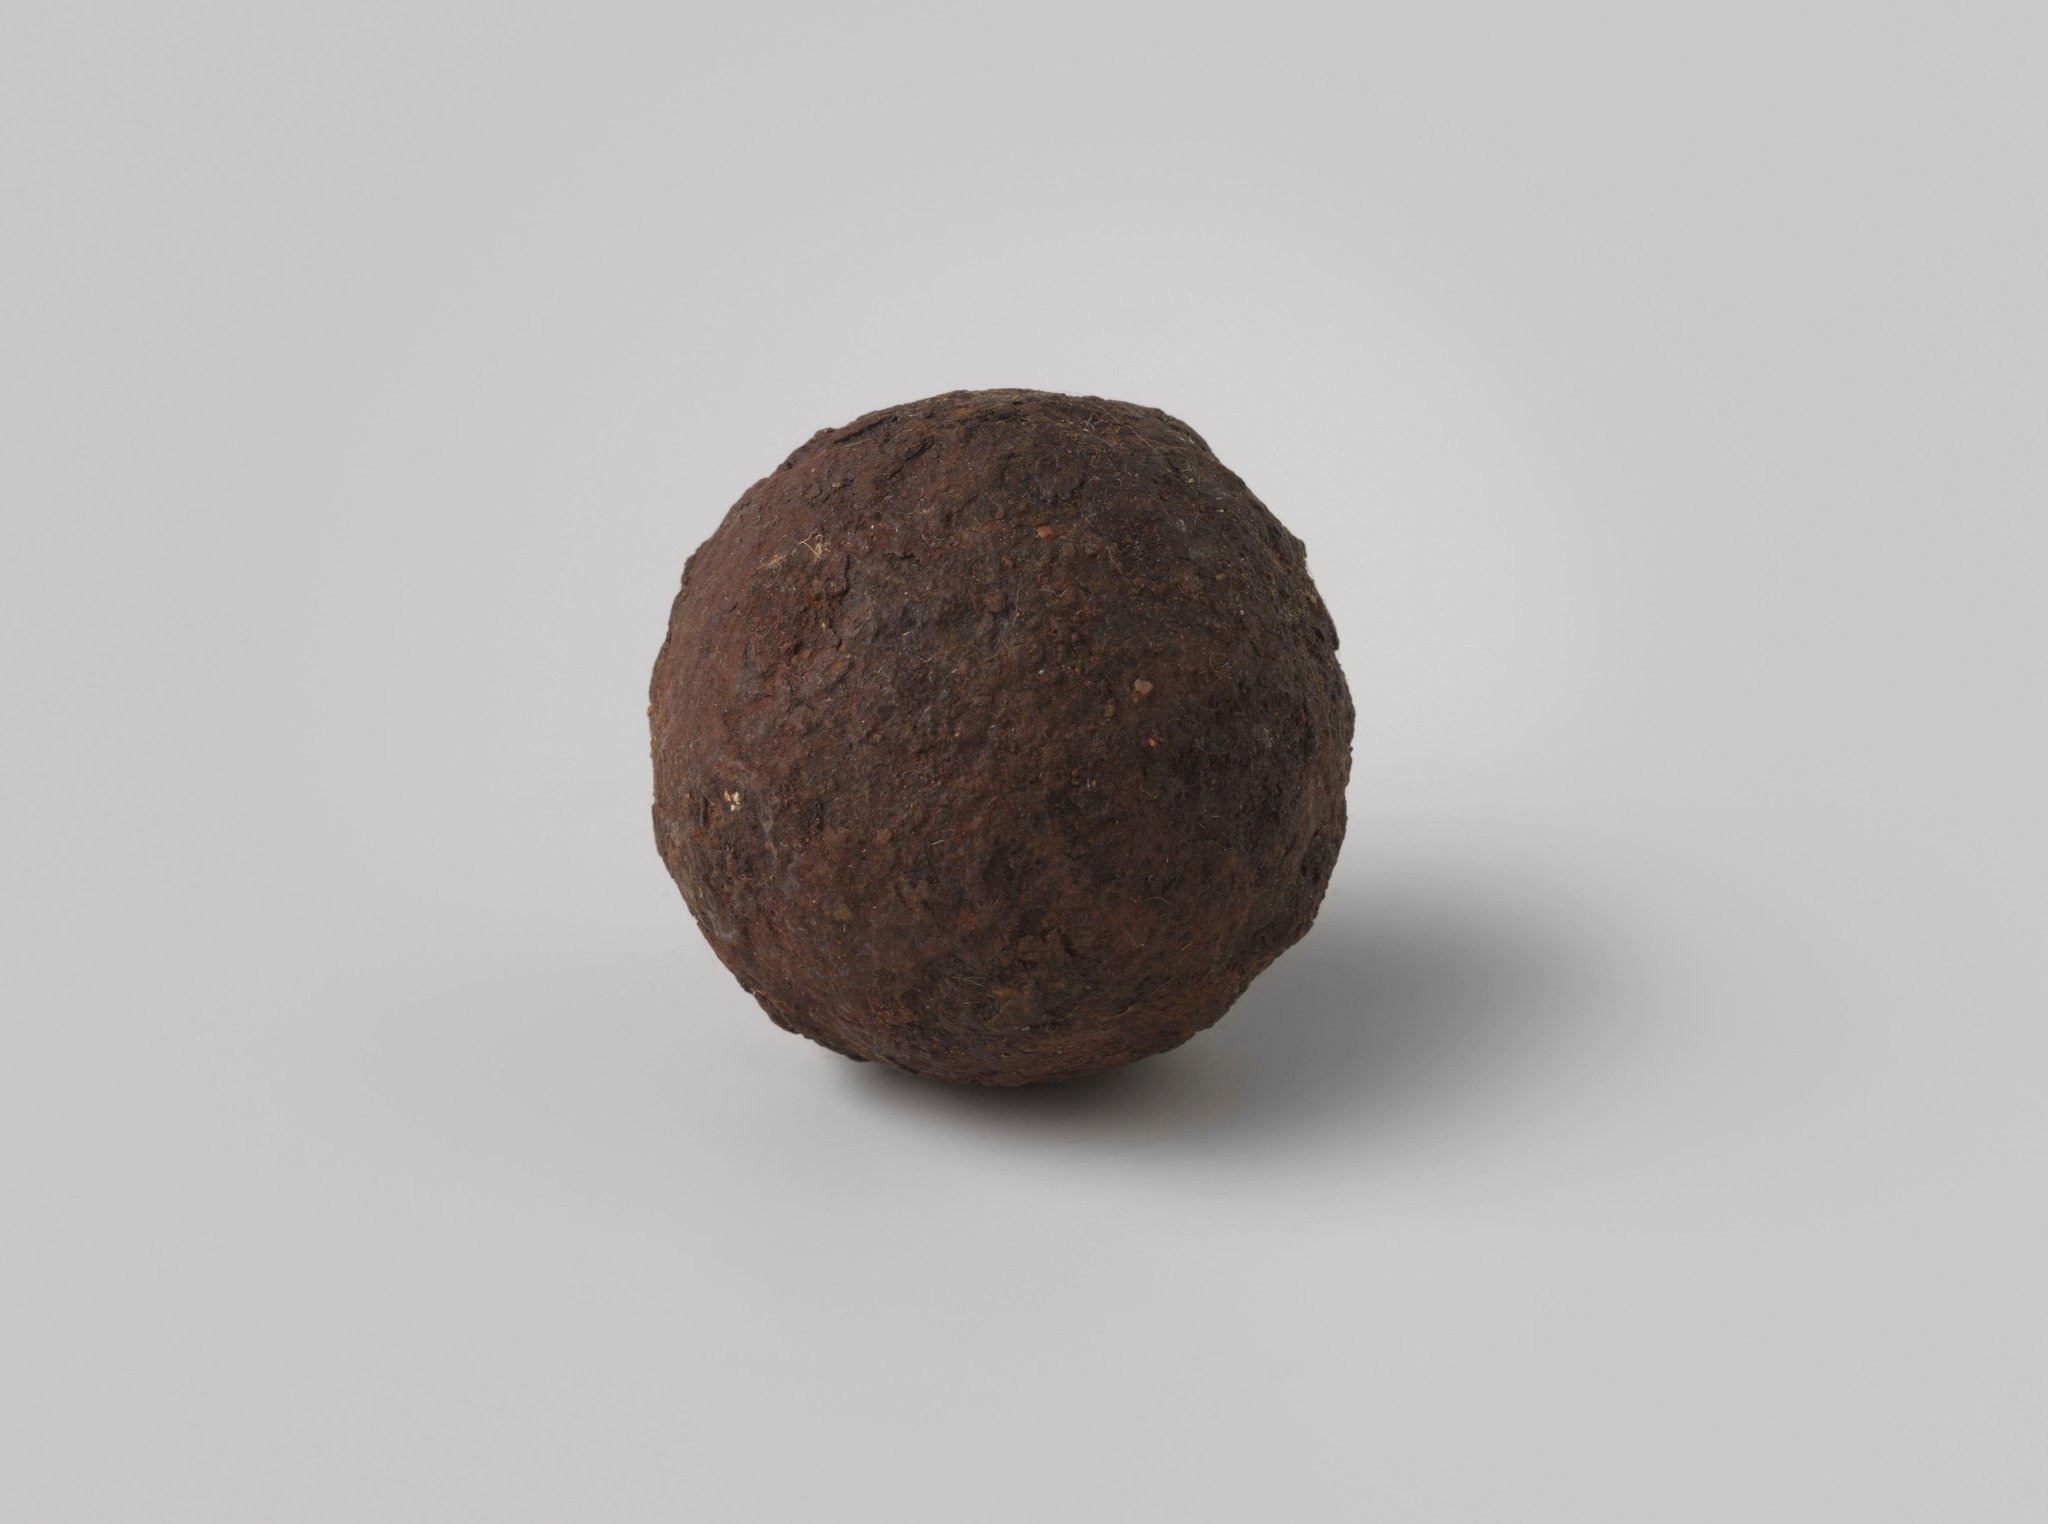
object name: bullet ammunition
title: Kogel uit het wrak van de Oost-Indiëvaarder Hollandia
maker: Anonymous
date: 1700-1743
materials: iron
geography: netherlands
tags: verenigde oostindische compagnie, hollandia (schip), annet